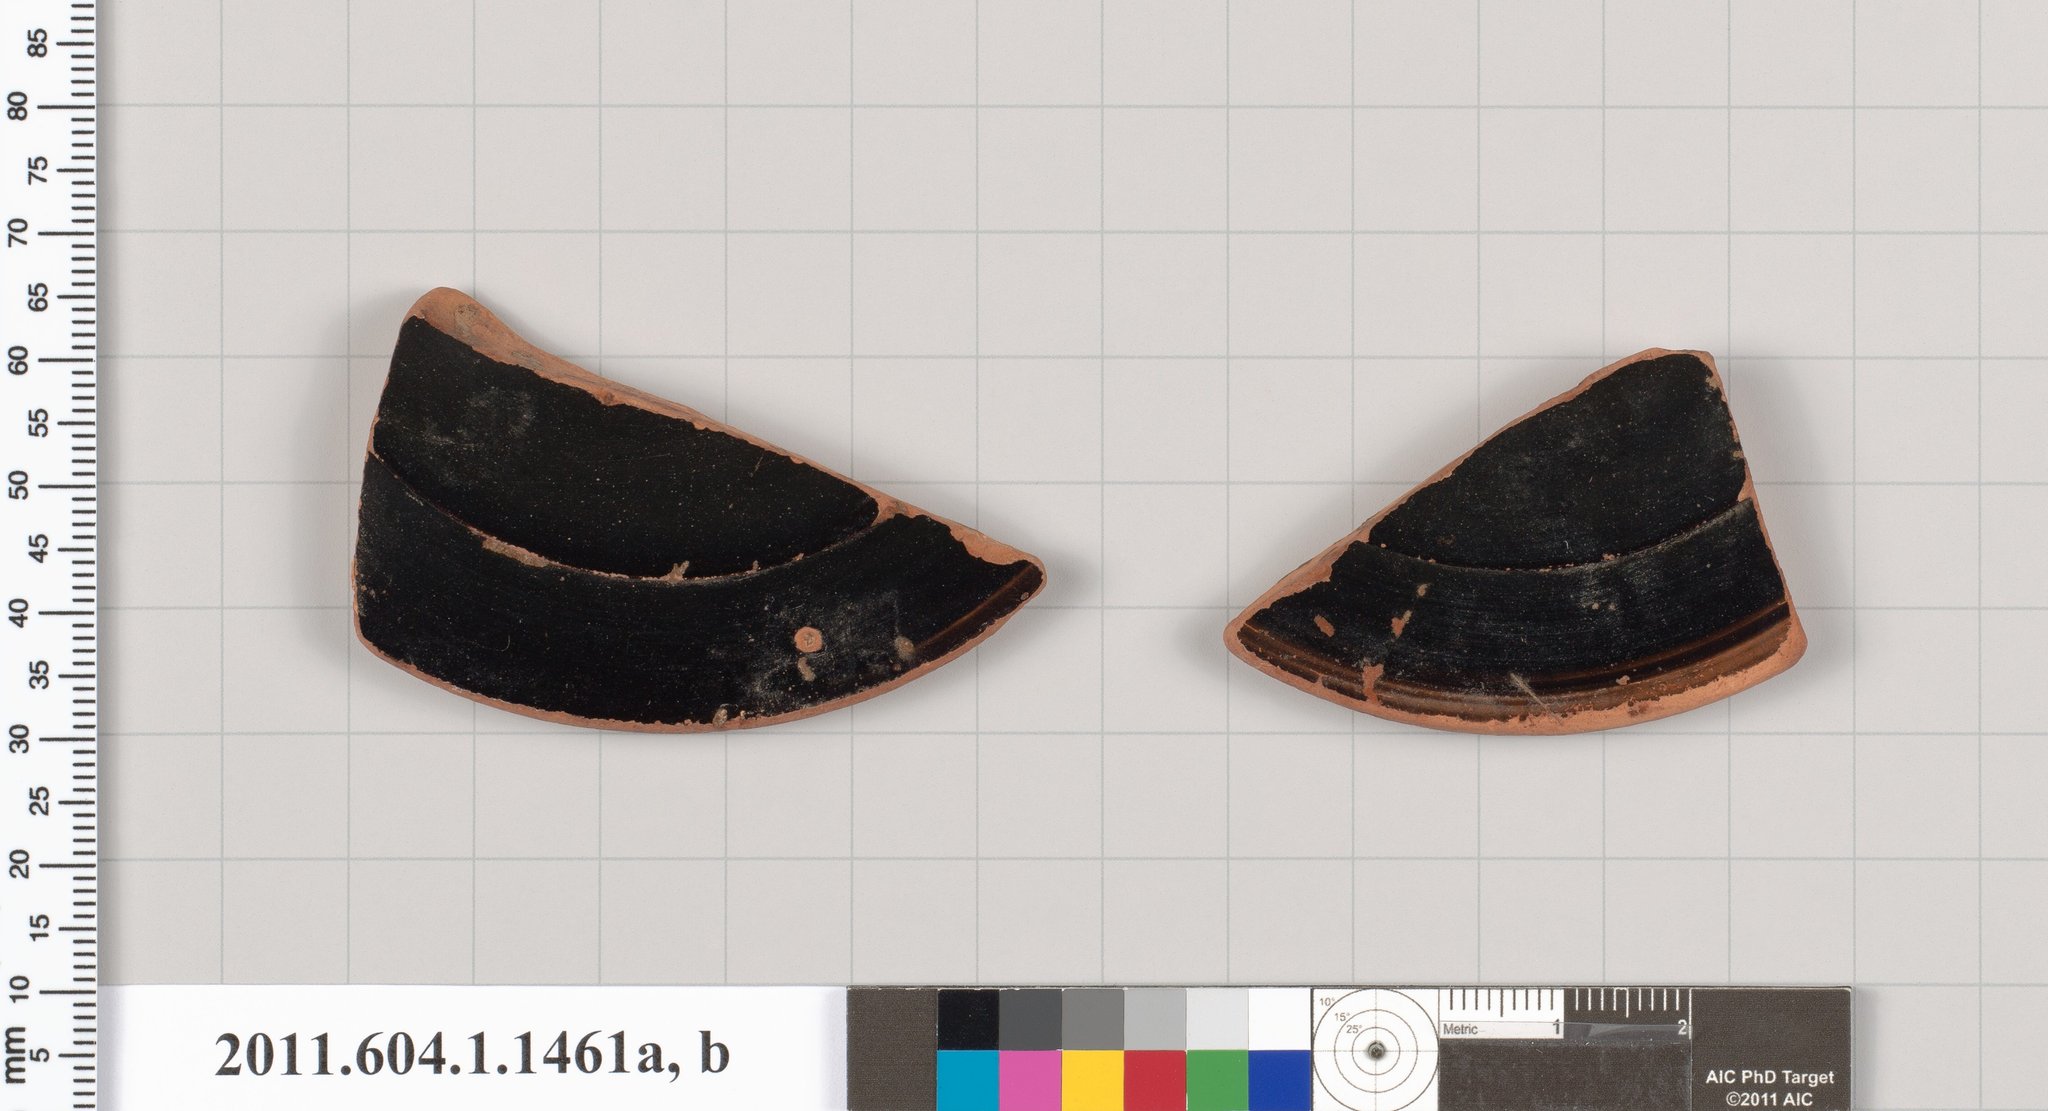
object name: kylix fragment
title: Terracotta fragments of a kylix (drinking cup)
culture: greek, attic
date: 500-401 BCE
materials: terracotta